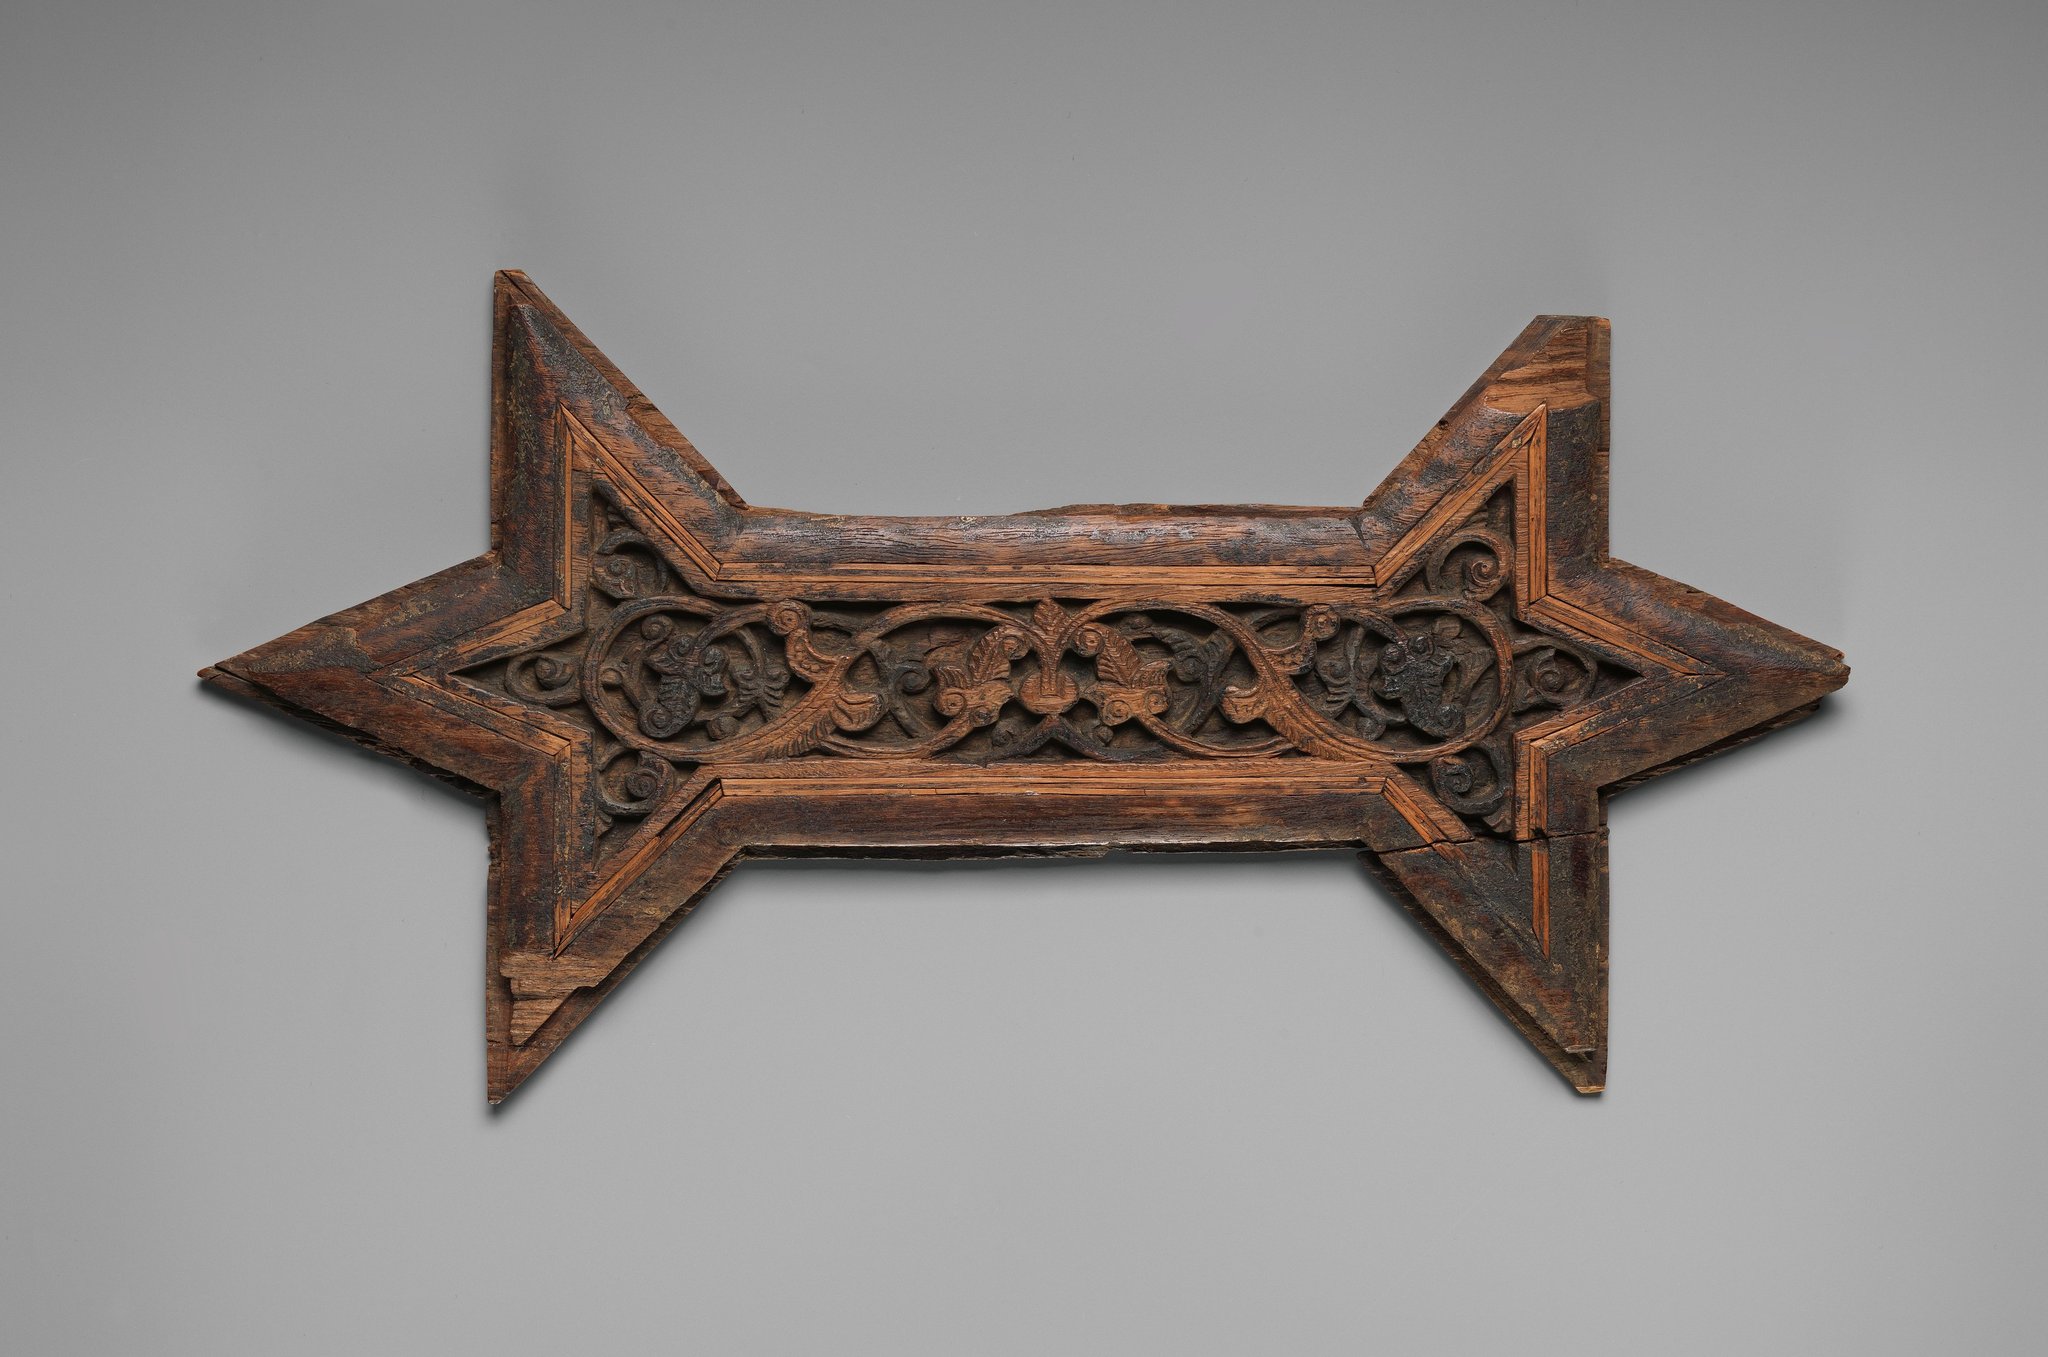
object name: panel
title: Panel from Sultan Lajin's Minbar at the Mosque of Ibn Tulun, Cairo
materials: wood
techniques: carving, inlay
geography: egypt